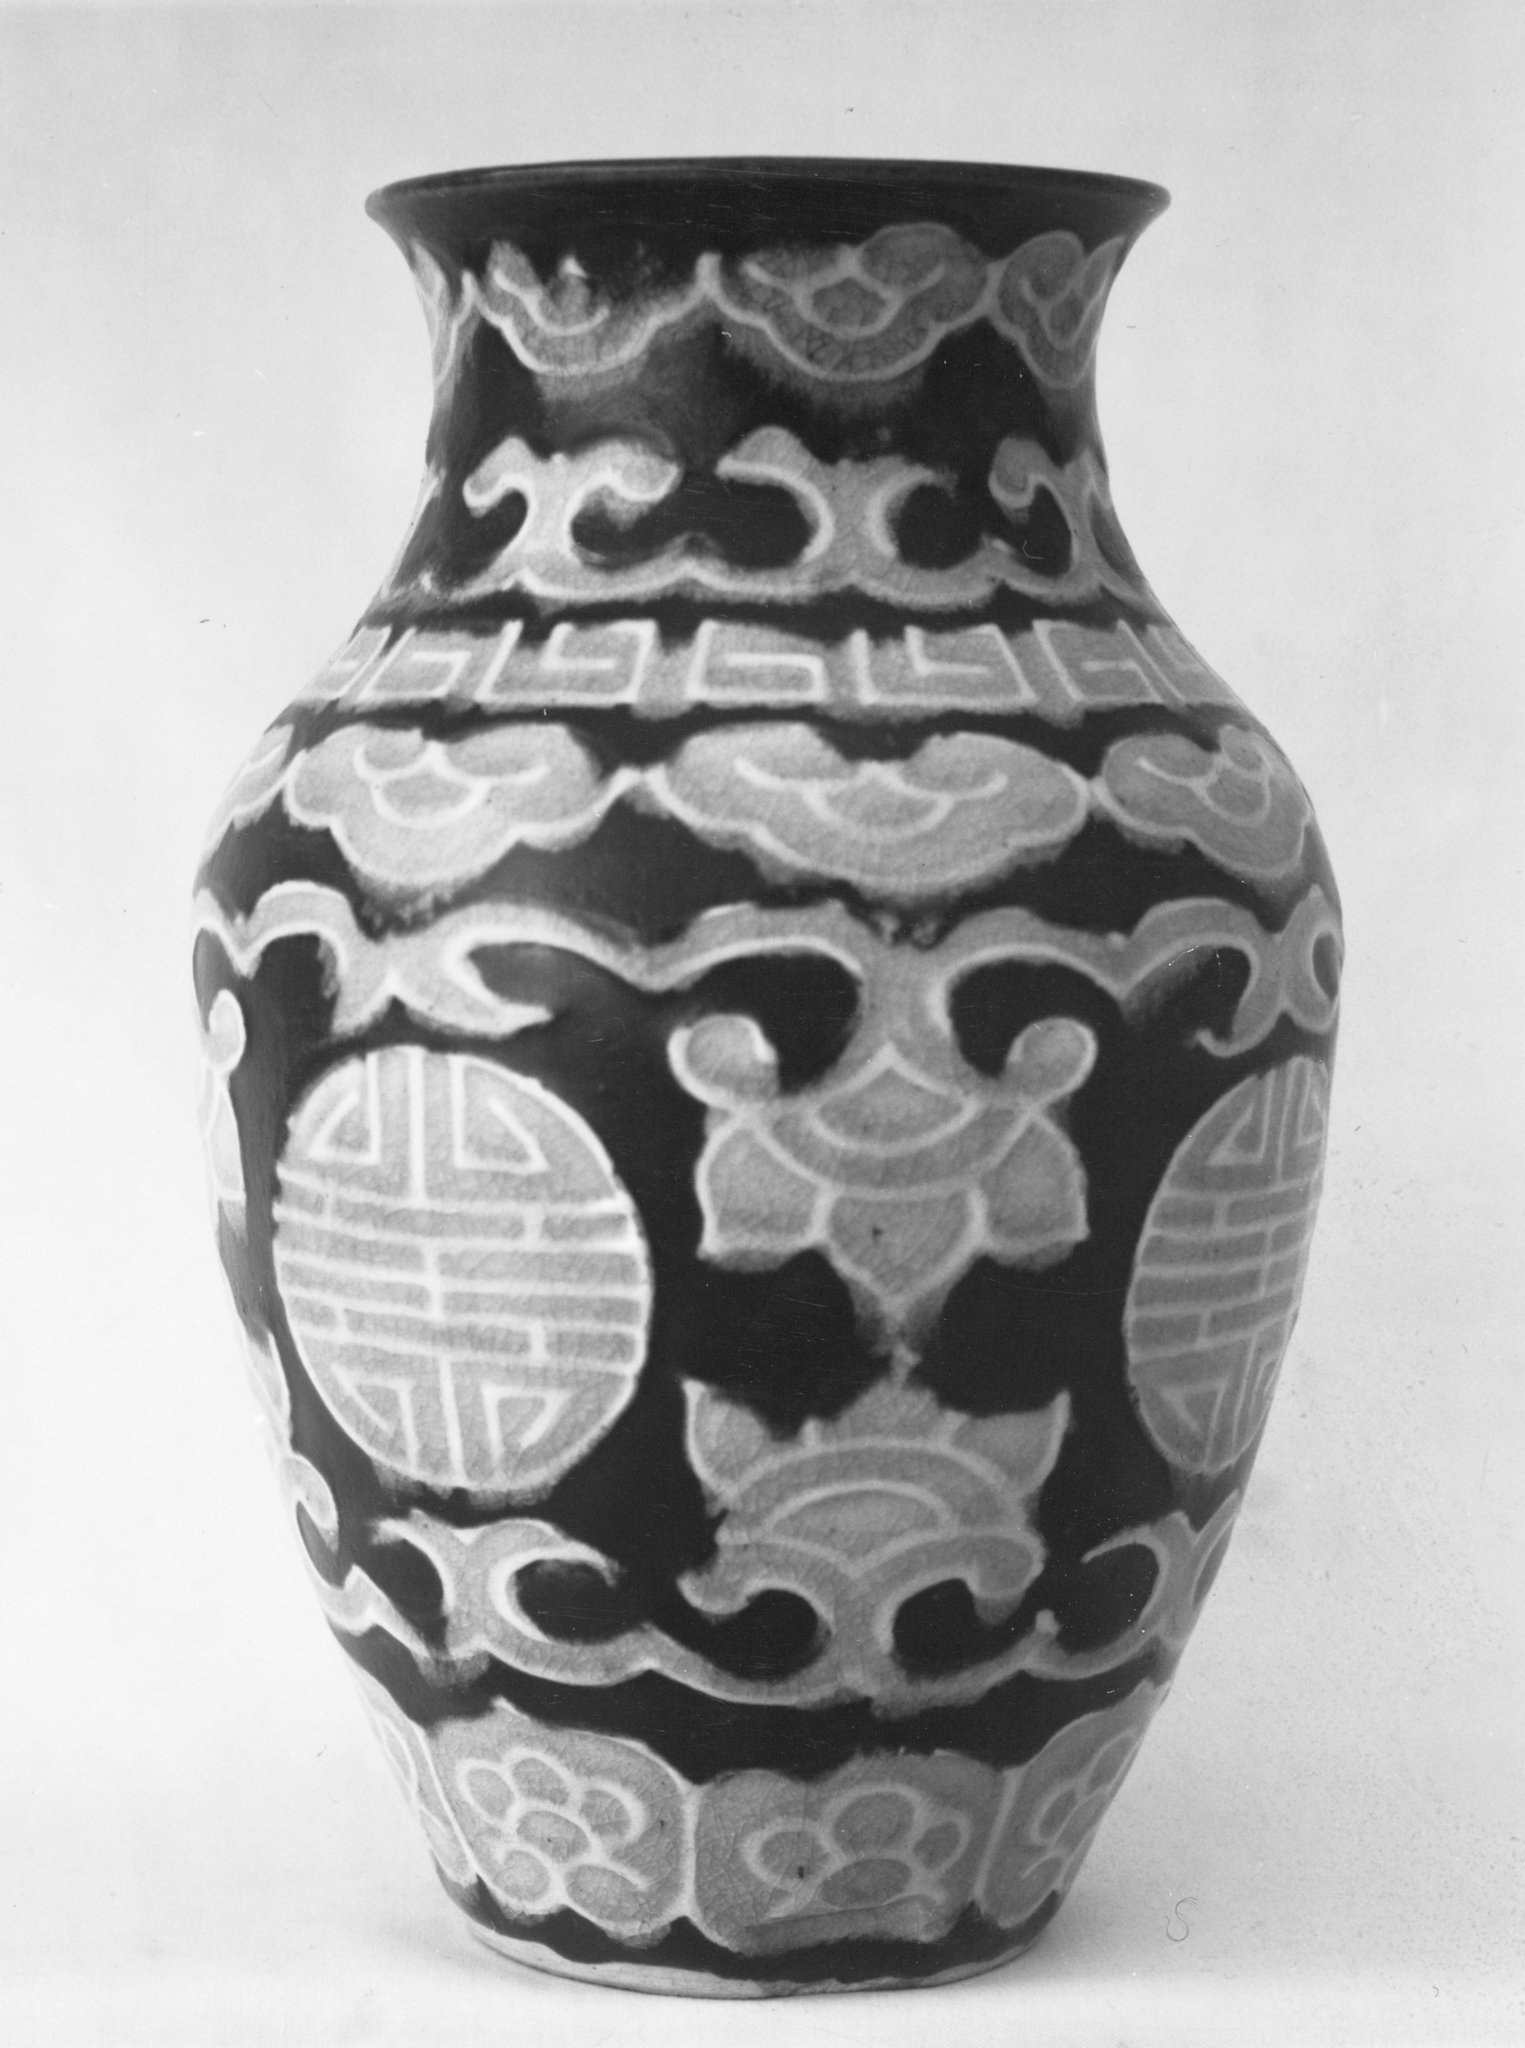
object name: vase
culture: japanese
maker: eiraku hozen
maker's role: artist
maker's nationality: japanese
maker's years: 1795-1854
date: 1801-1900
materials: clay, glaze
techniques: polychrome, relief